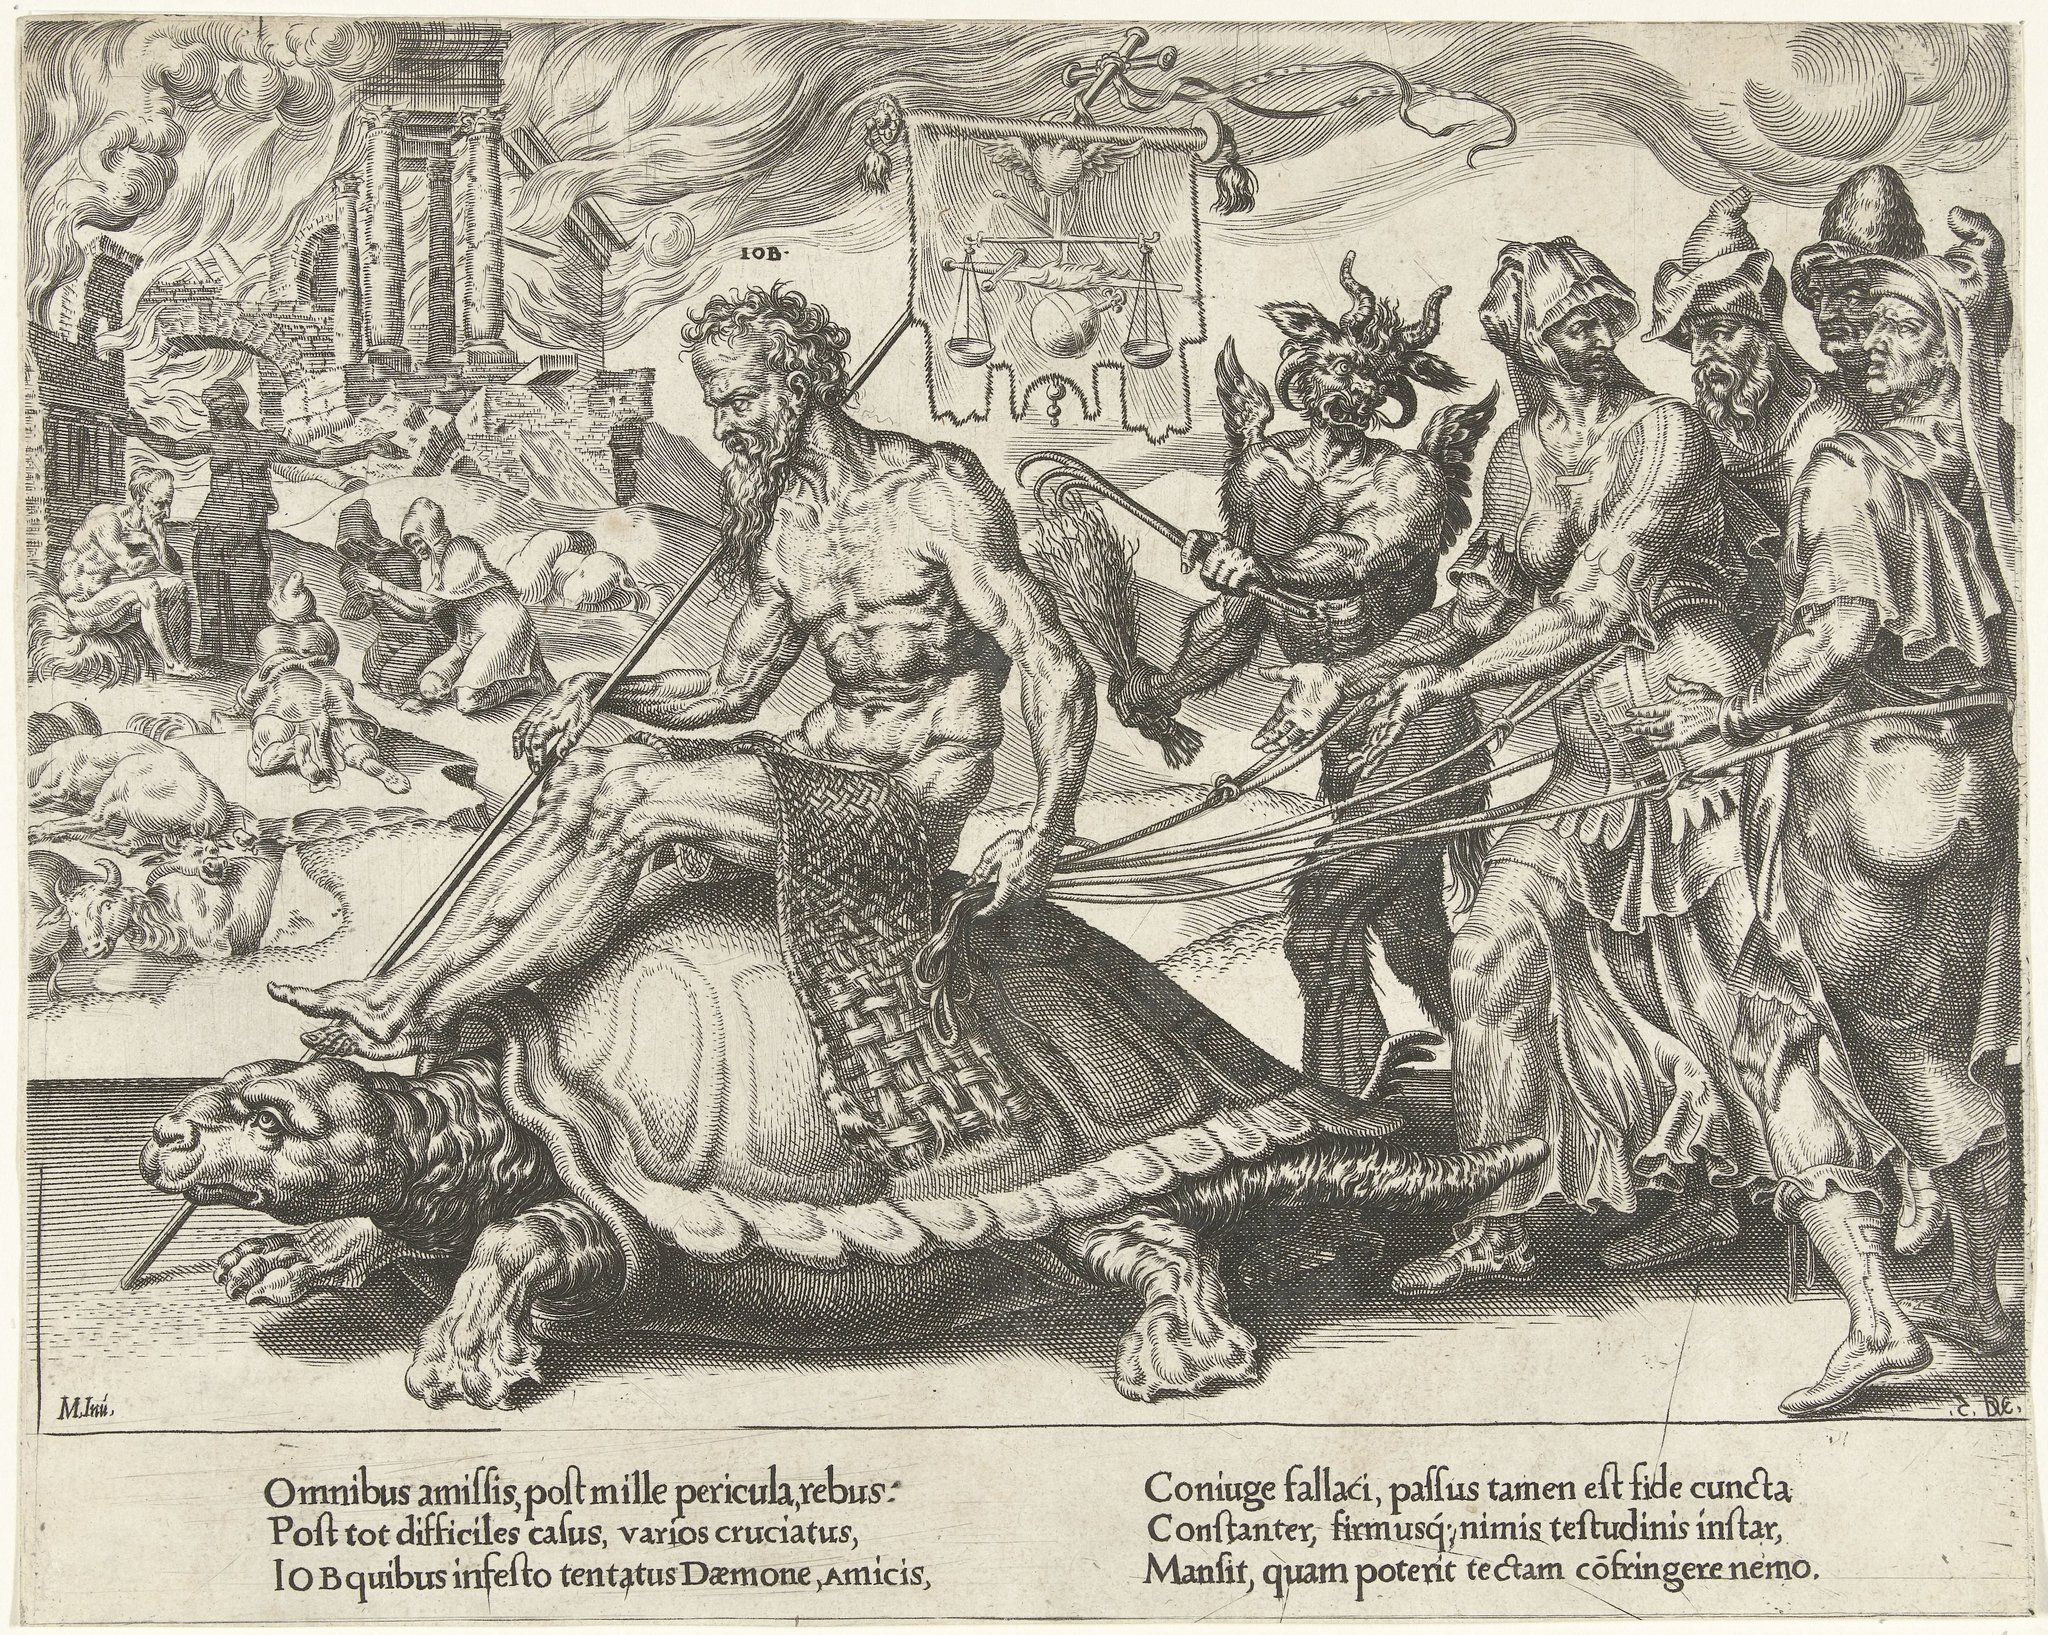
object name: print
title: Triomf van Job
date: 1559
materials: paper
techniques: engraving, etching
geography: antwerp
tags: tortoises, turtles, job on the dunghill visited by his friends (and wife), triumphs (allegorical and symbolic), satan scourging job, male persons from the old testament (with name) (not in biblical context), the death of job's children, job's sheep and shepherds struck by lightning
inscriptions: collector's mark: Lugt 2228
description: Op de voorgrond Job, rijdend op een schildpad. In zijn rechterhand een kruis met een vaandel. Op het vaandel een weegschaal, een gevleugeld hart en een vlammend zwaard dat het hart lossnijdt van de wereld. Achter Job volgen: de duivel die hem met allerlei plagen van zijn geloof probeert af te brengen, zijn vrouw die hem aanspoort zijn geloof af te vallen en zijn drie vrienden die niet in hem geloven. Op de achtergrond de beproevingen die Job onderging: de dood van zijn kudde, de dood van zijn kinderen en Job op de mesthoop, bedekt met zweren. De prent heeft een Latijns opschrift van zes regels en maakt deel uit van een achtdelige serie over de triomf van de Lijdzaamheid.